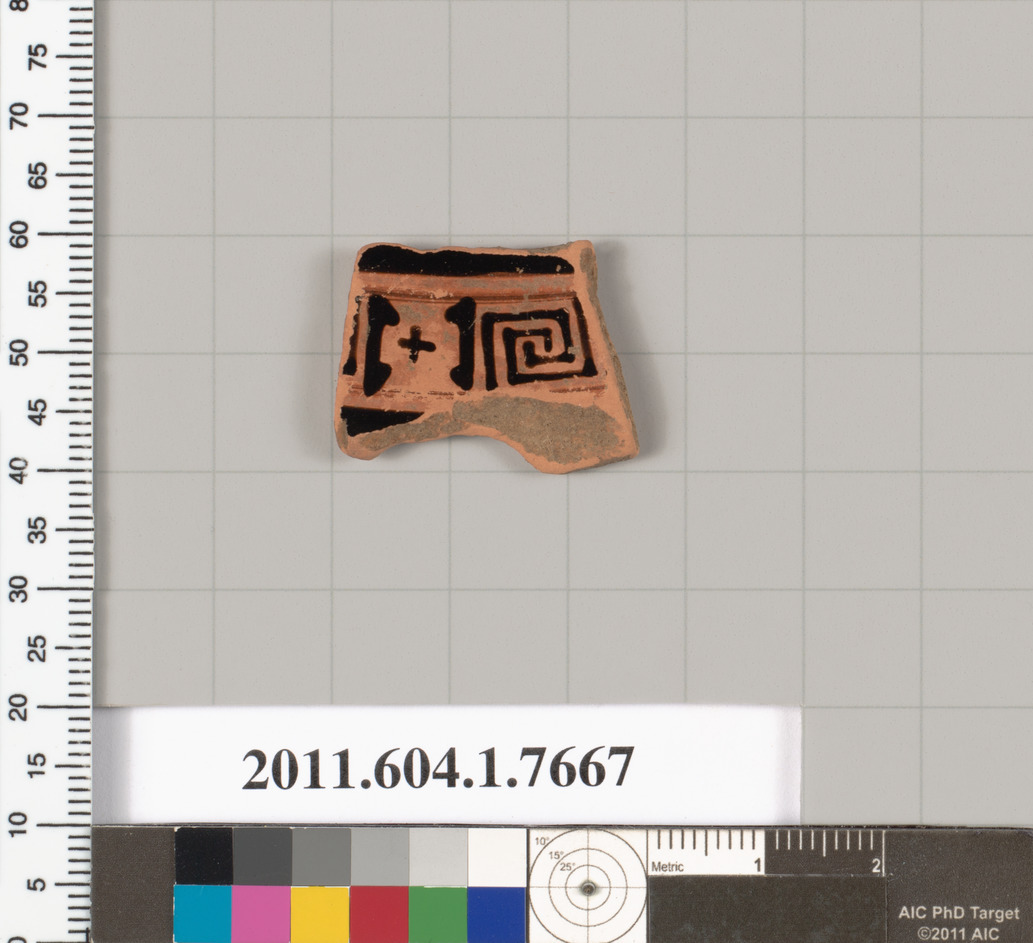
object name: kylix fragment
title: Terracotta fragment of a kylix (drinking cup)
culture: greek, attic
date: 460-450 BCE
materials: terracotta